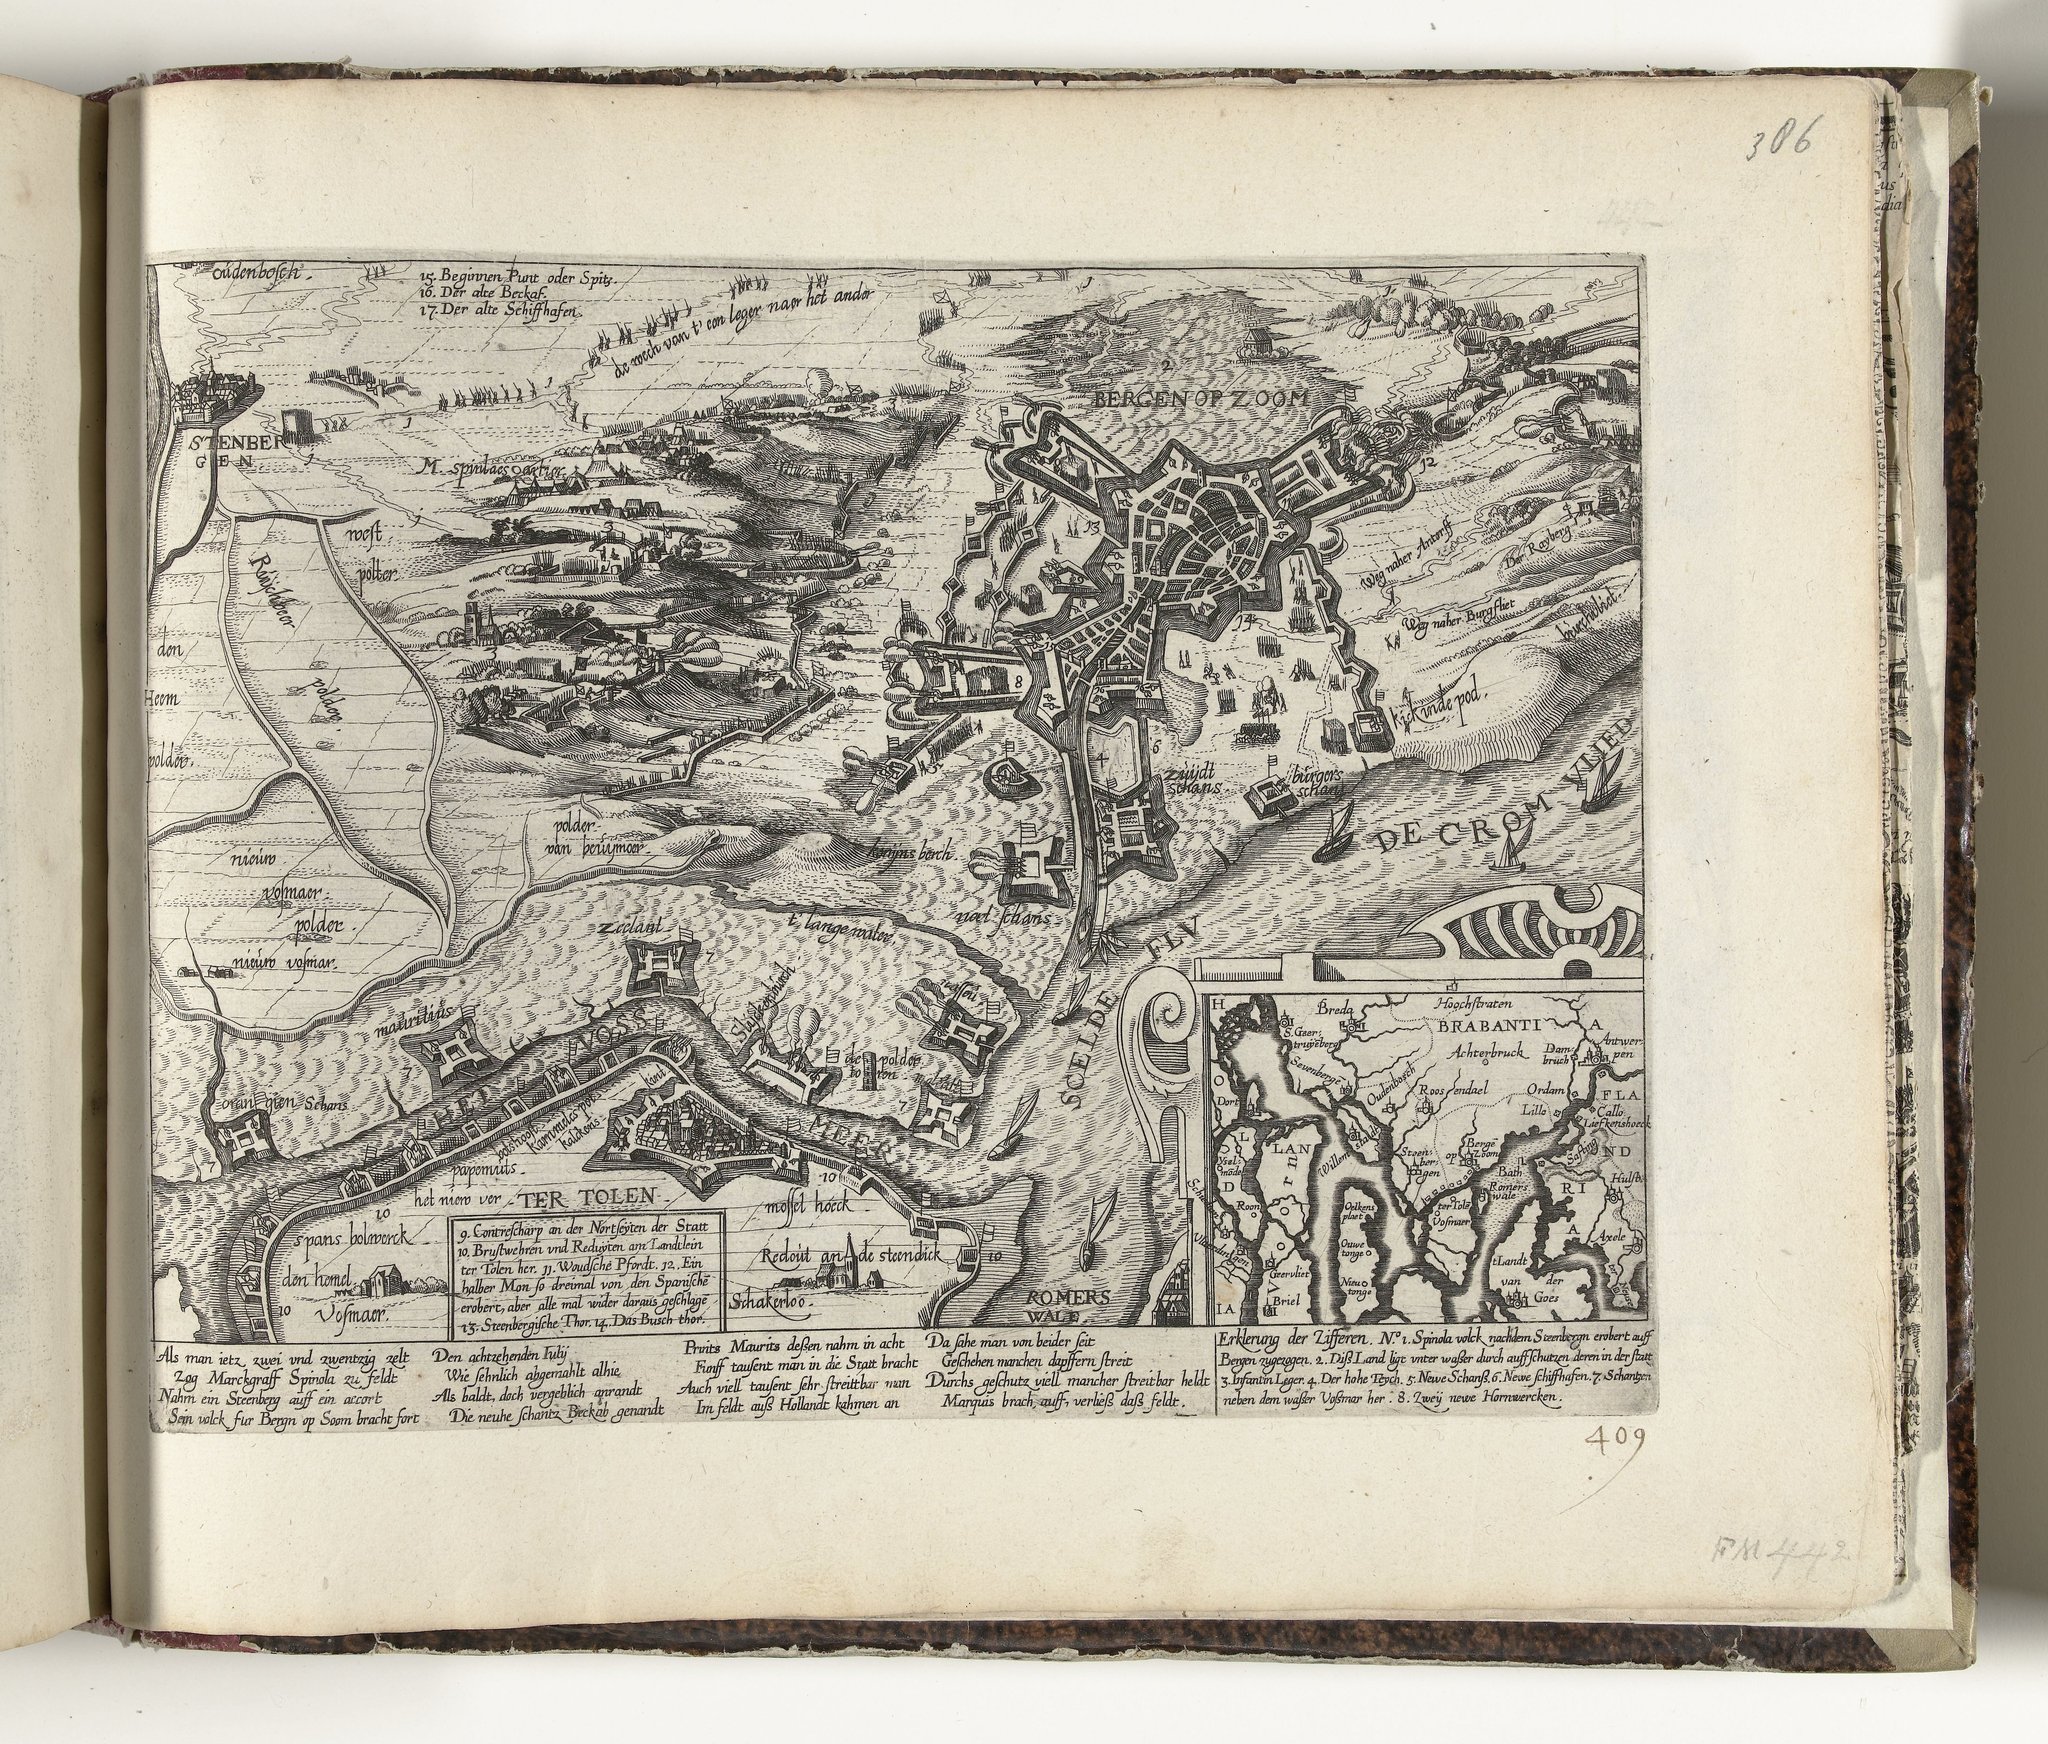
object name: print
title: Beleg van Bergen op Zoom door Spinola, 1622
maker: frans hogenberg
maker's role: print maker, publisher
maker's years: 1538-1590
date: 1622-1624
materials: paper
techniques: etching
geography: cologne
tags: maps of separate countries or regions, siege, position war, bergen op zoom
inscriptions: inscription: ‘409’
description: Beleg van Bergen op Zoom door Spinola, 18 juli tot 27 augustus 1622. Kaart van Bergen op Zoom en omringend gebied met de verschillende schansen en de posities van het Spaanse leger. Onderaan in een inzet een kaartje van de Zeeuwse eilanden en de Scheldemonding. Met de bijbehorende legenda van de nummers 1-17. Met onderschrift van 16 regels in het Duits. Rechtsonder met pen genummerd: 409. De prent maakt deel uit van een album.